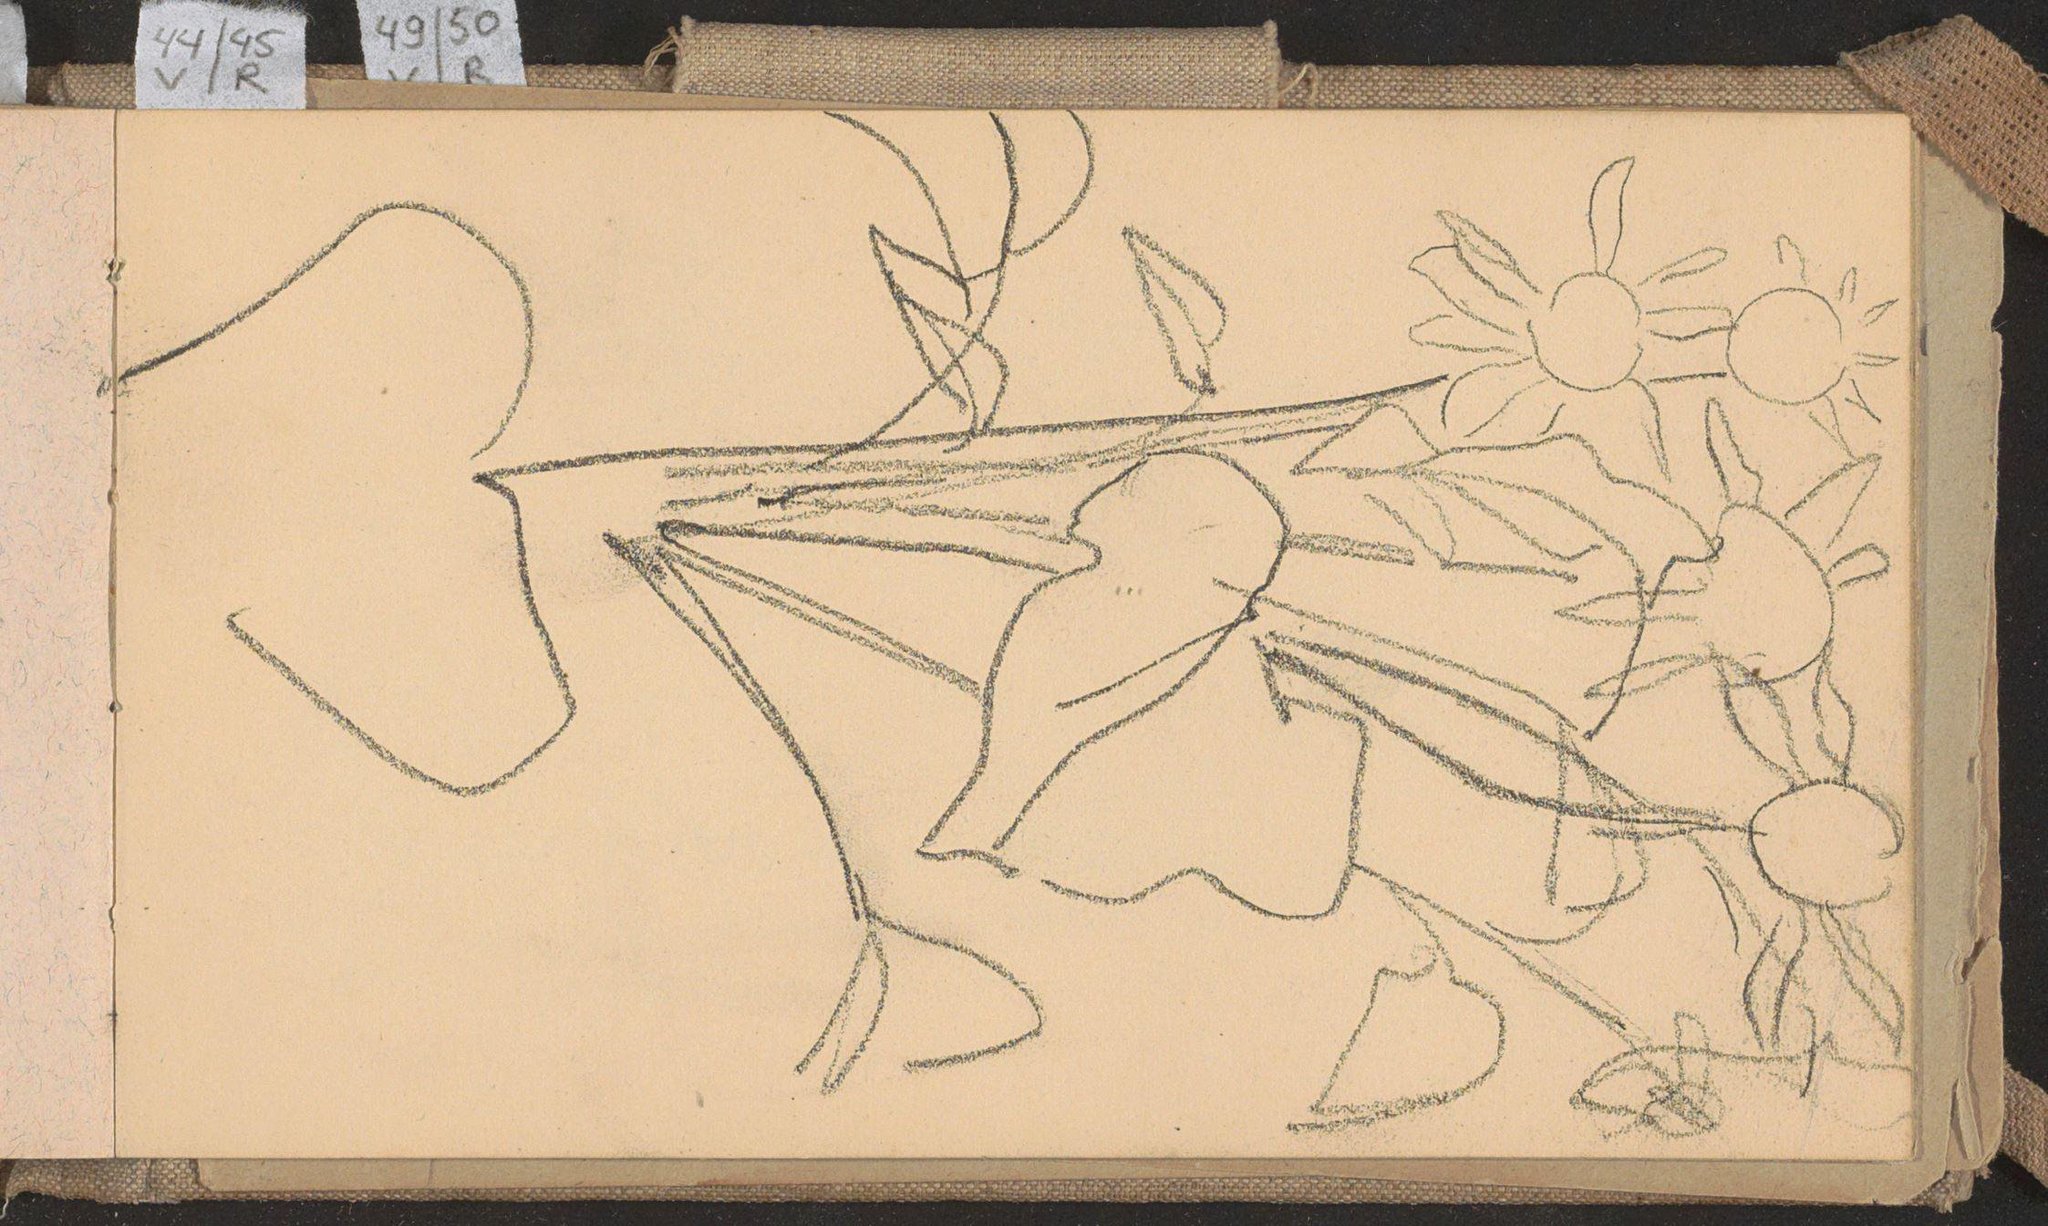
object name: sketchbook leaf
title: Zonnebloemen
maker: antoon derkinderen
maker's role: draughtsman, painter, print maker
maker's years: 1859-1925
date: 1892-1901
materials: paper, pencil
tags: flowers: sunflower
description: Blad 44 recto uit een schetsboek met 51 bladen.